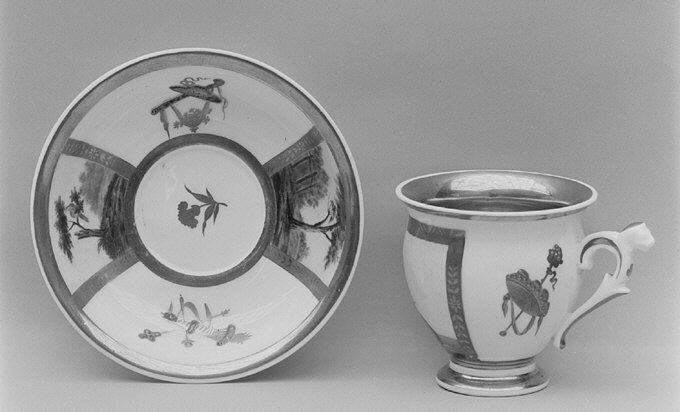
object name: cup and saucer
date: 1801-1833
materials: hard paste porcelain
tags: flowers,trees